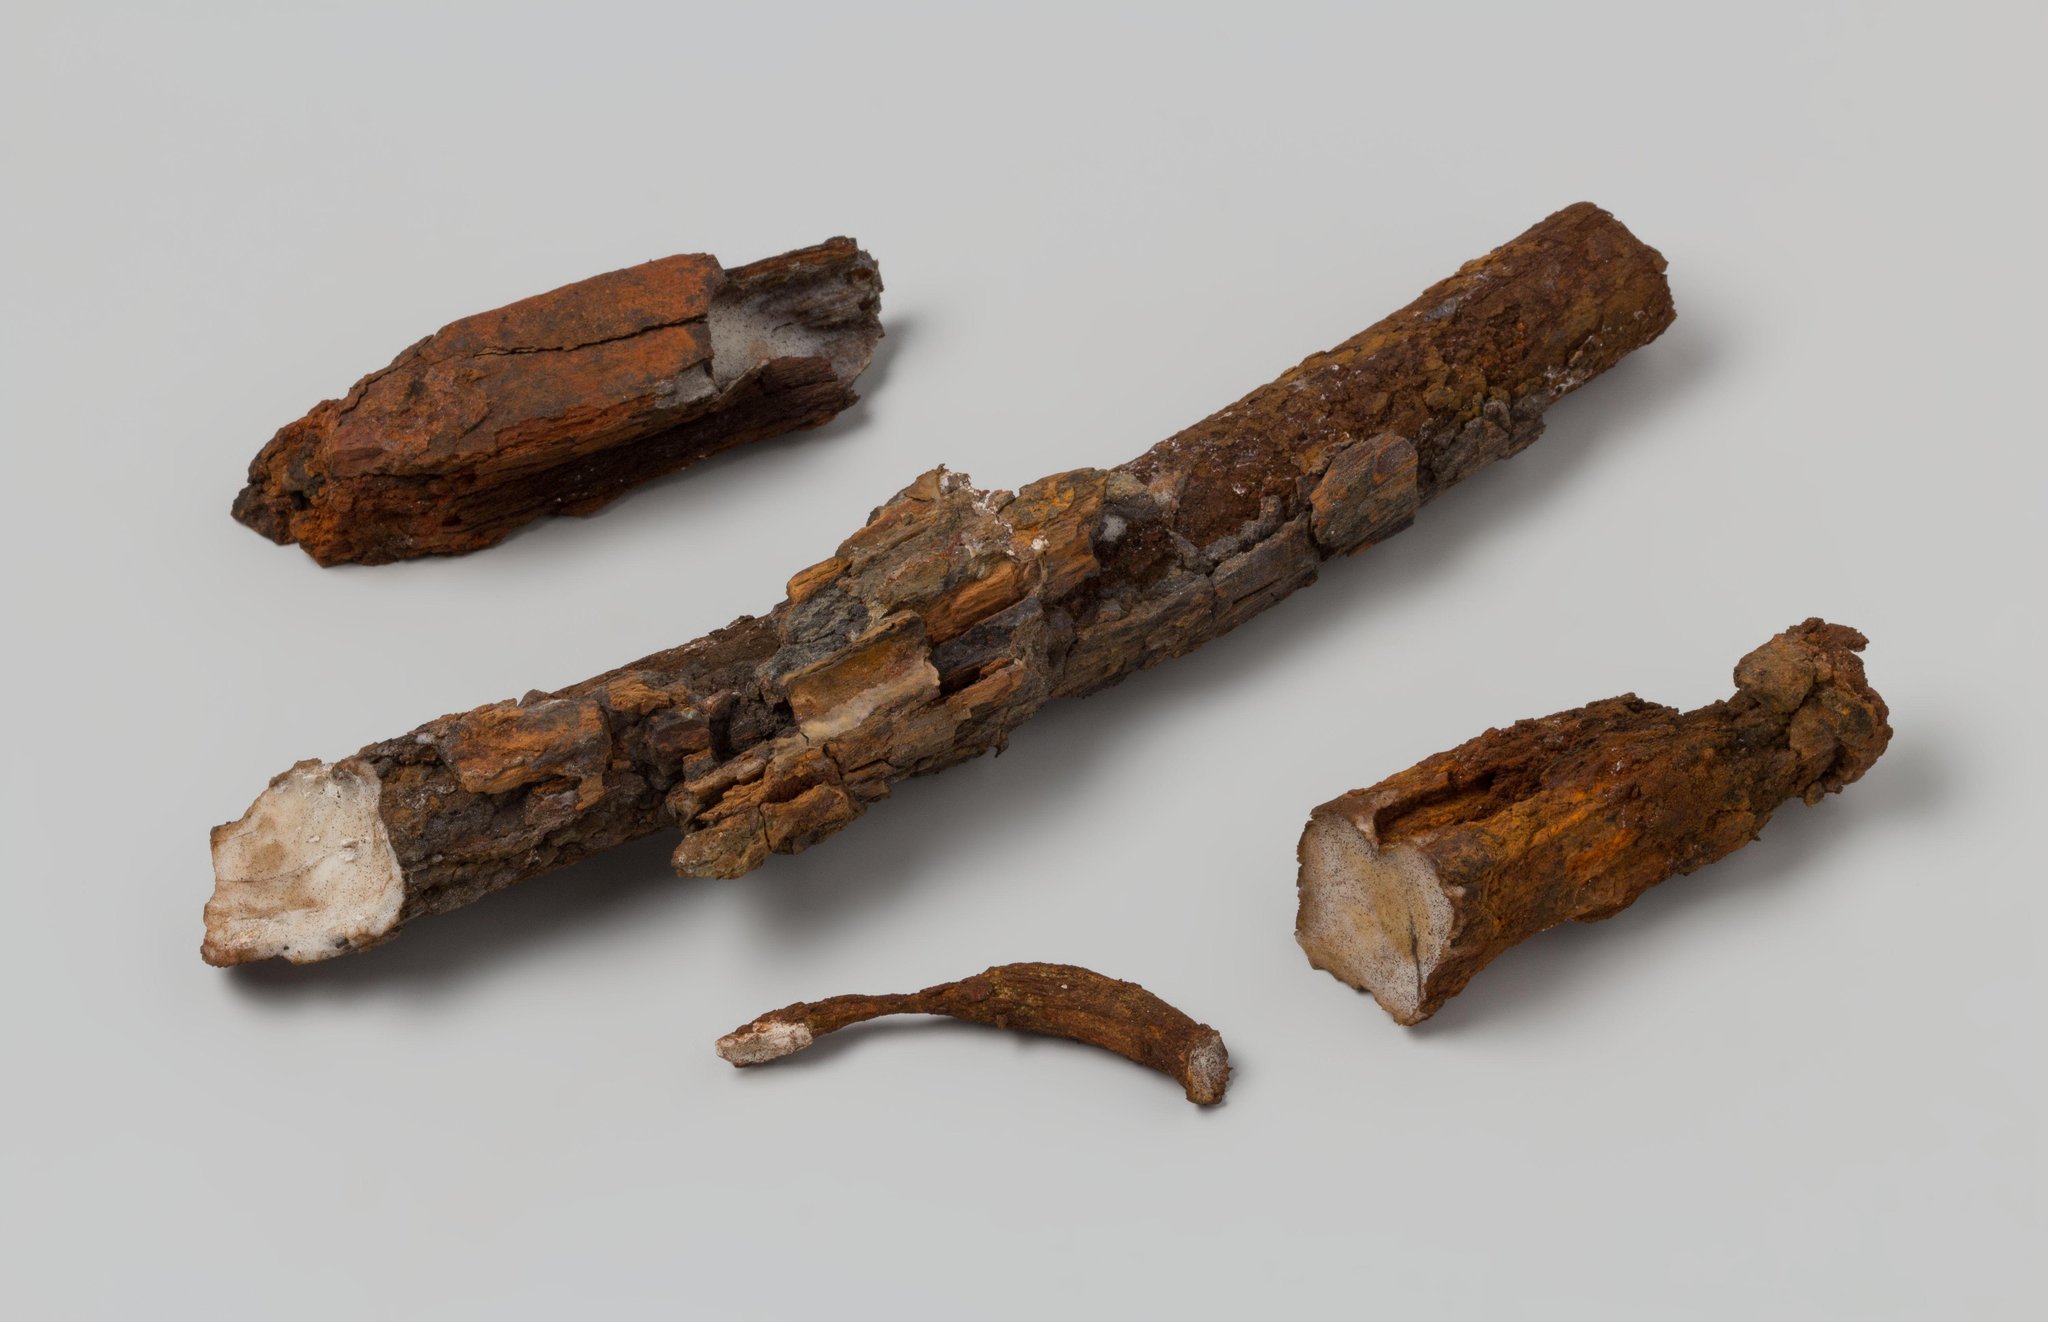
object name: artifact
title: Met siliconen (rubber) gevulde concretie uit het wrak van de in 1735 vergane Oost-Indiëvaarder 't Vliegend Hart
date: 1700-1735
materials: stone, rubber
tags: 't vliegend hart (schip), verenigde oostindische compagnie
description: Met siliconenrubber gevulde ijzerconcretie, bestaande uit 4 delen, vrij vierkant, passen aan elkaar. Waarschijnlijk hout aan de buitenzijde, dat wellicht tegen ijzer aangelegen heeft.